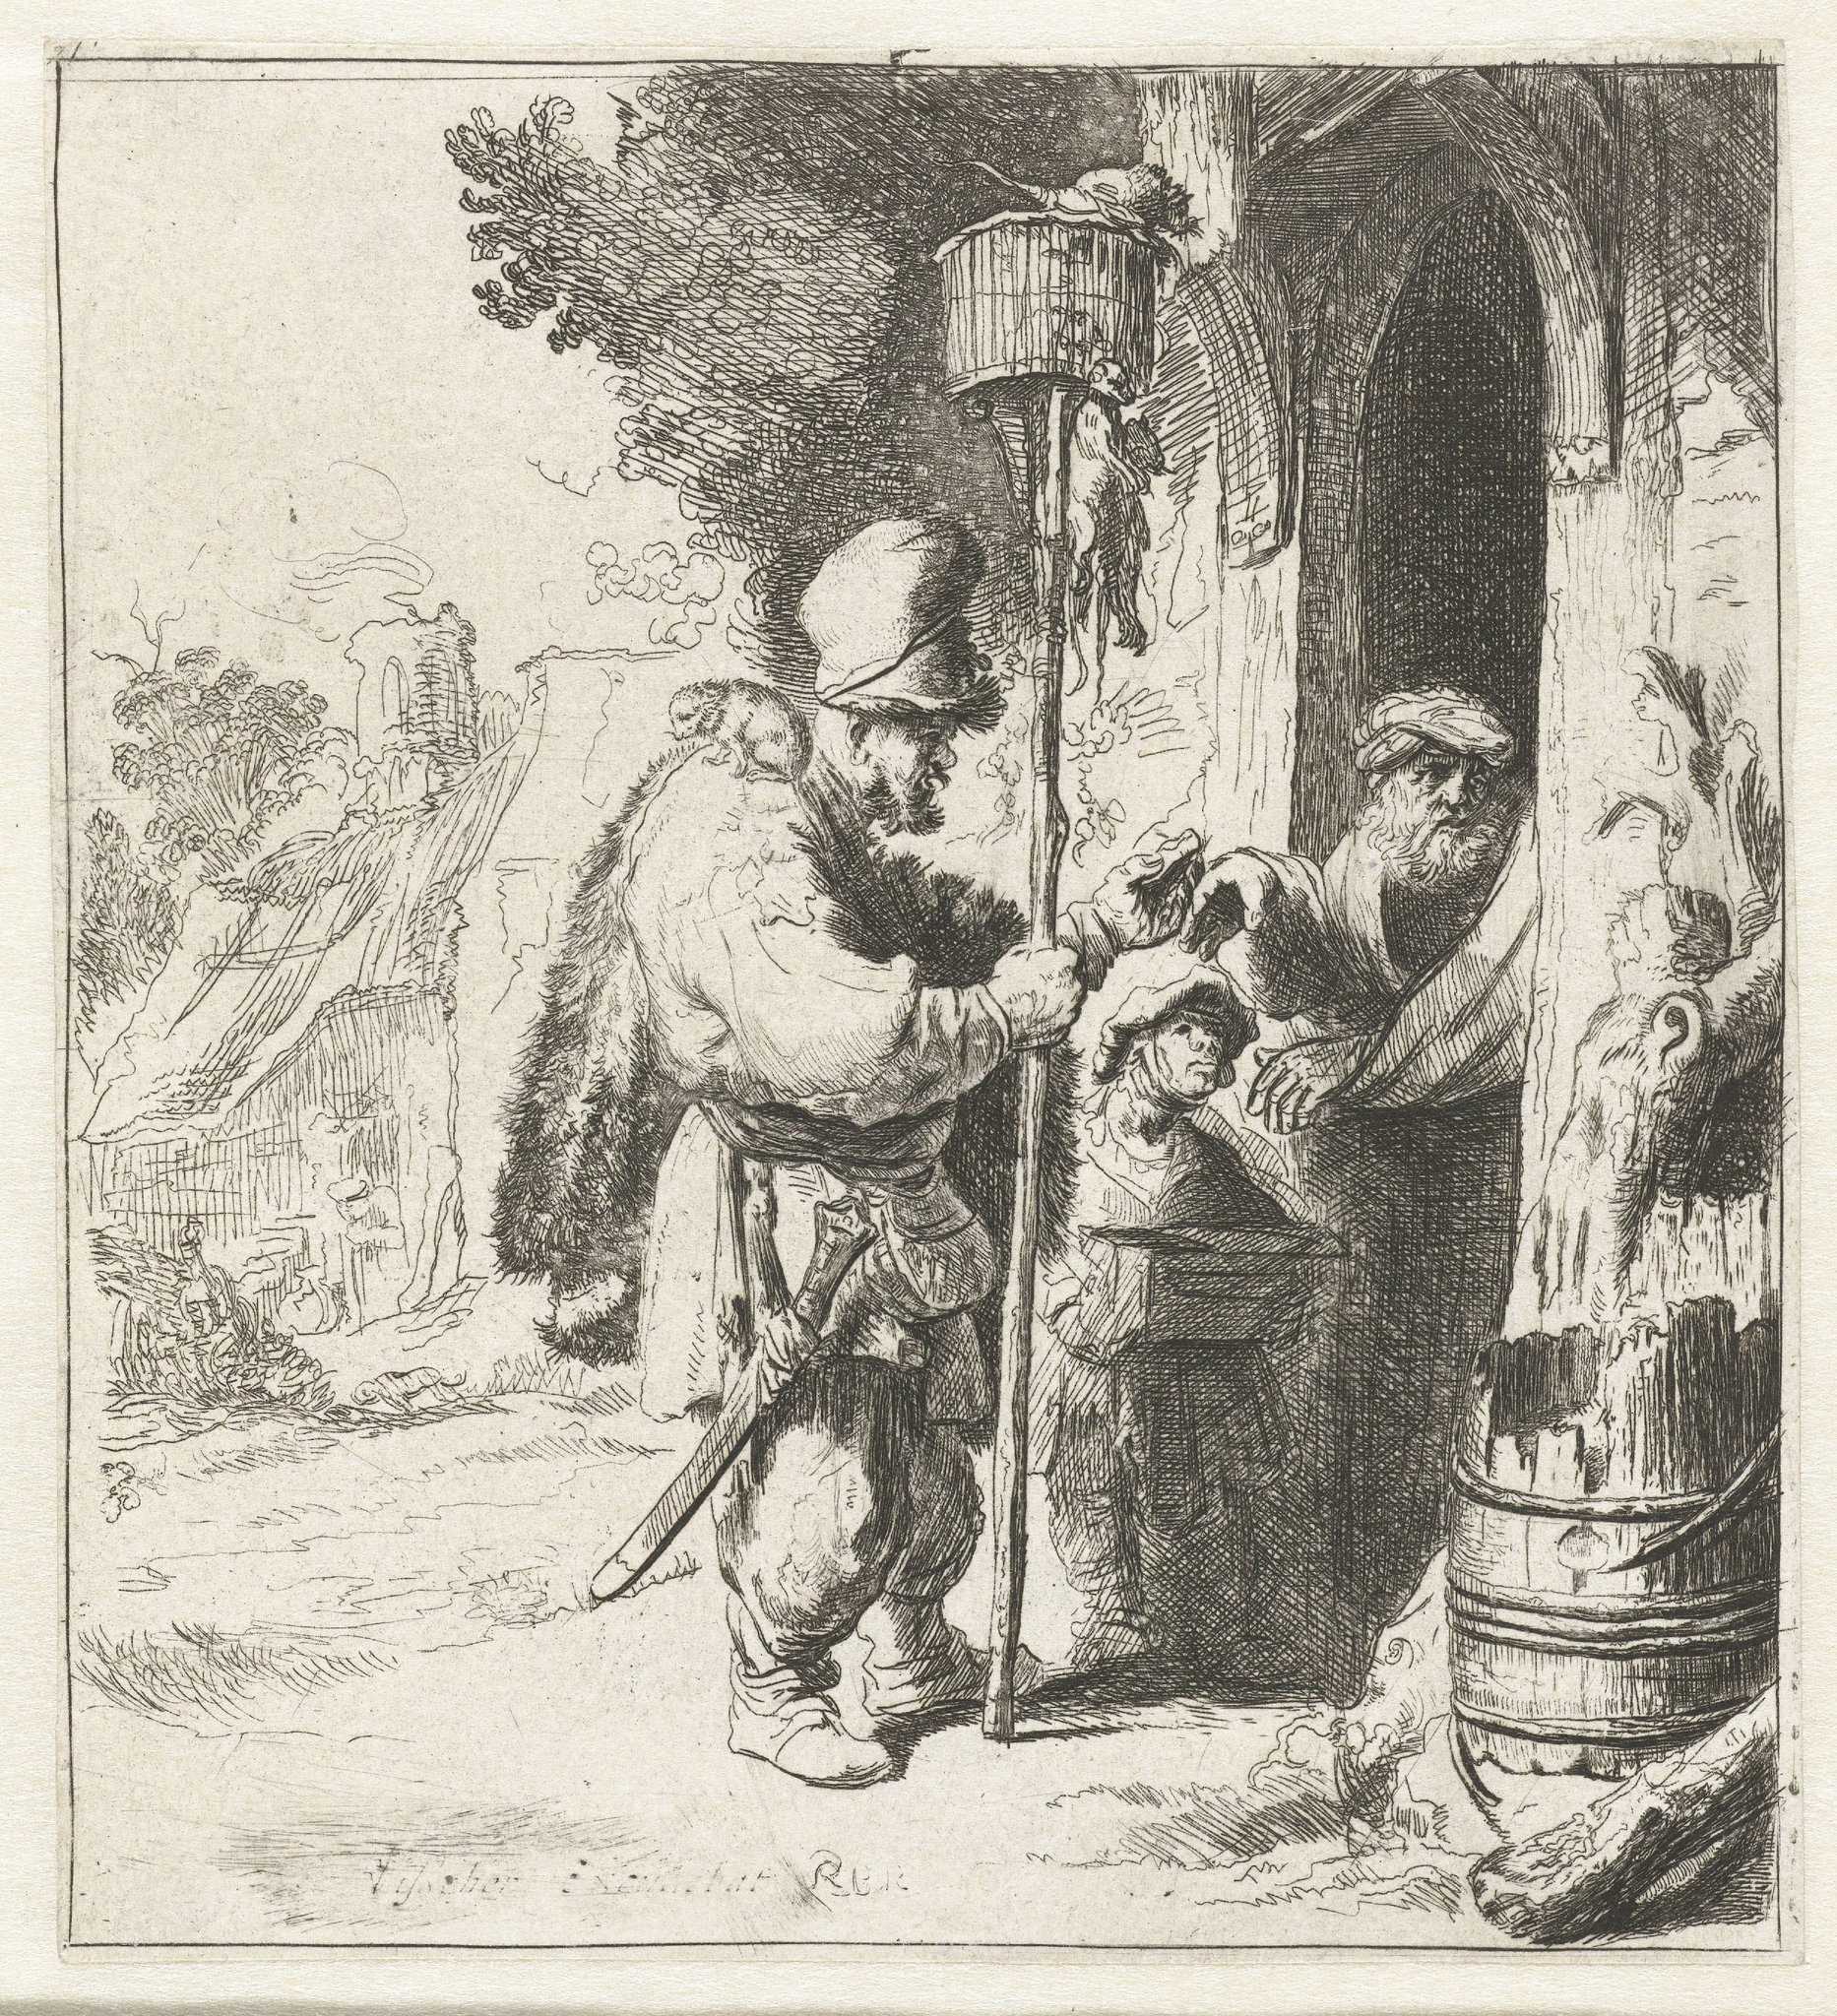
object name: print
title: The rat catcher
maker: Anonymous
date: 1632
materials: paper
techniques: etching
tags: rat exterminator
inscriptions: collector's mark: Lugt 2760, collector's mark: 556c, collector's mark: Lugt 2228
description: Spiegelbeeldige kopie naar de gelijknamige prent van Rembrandt.